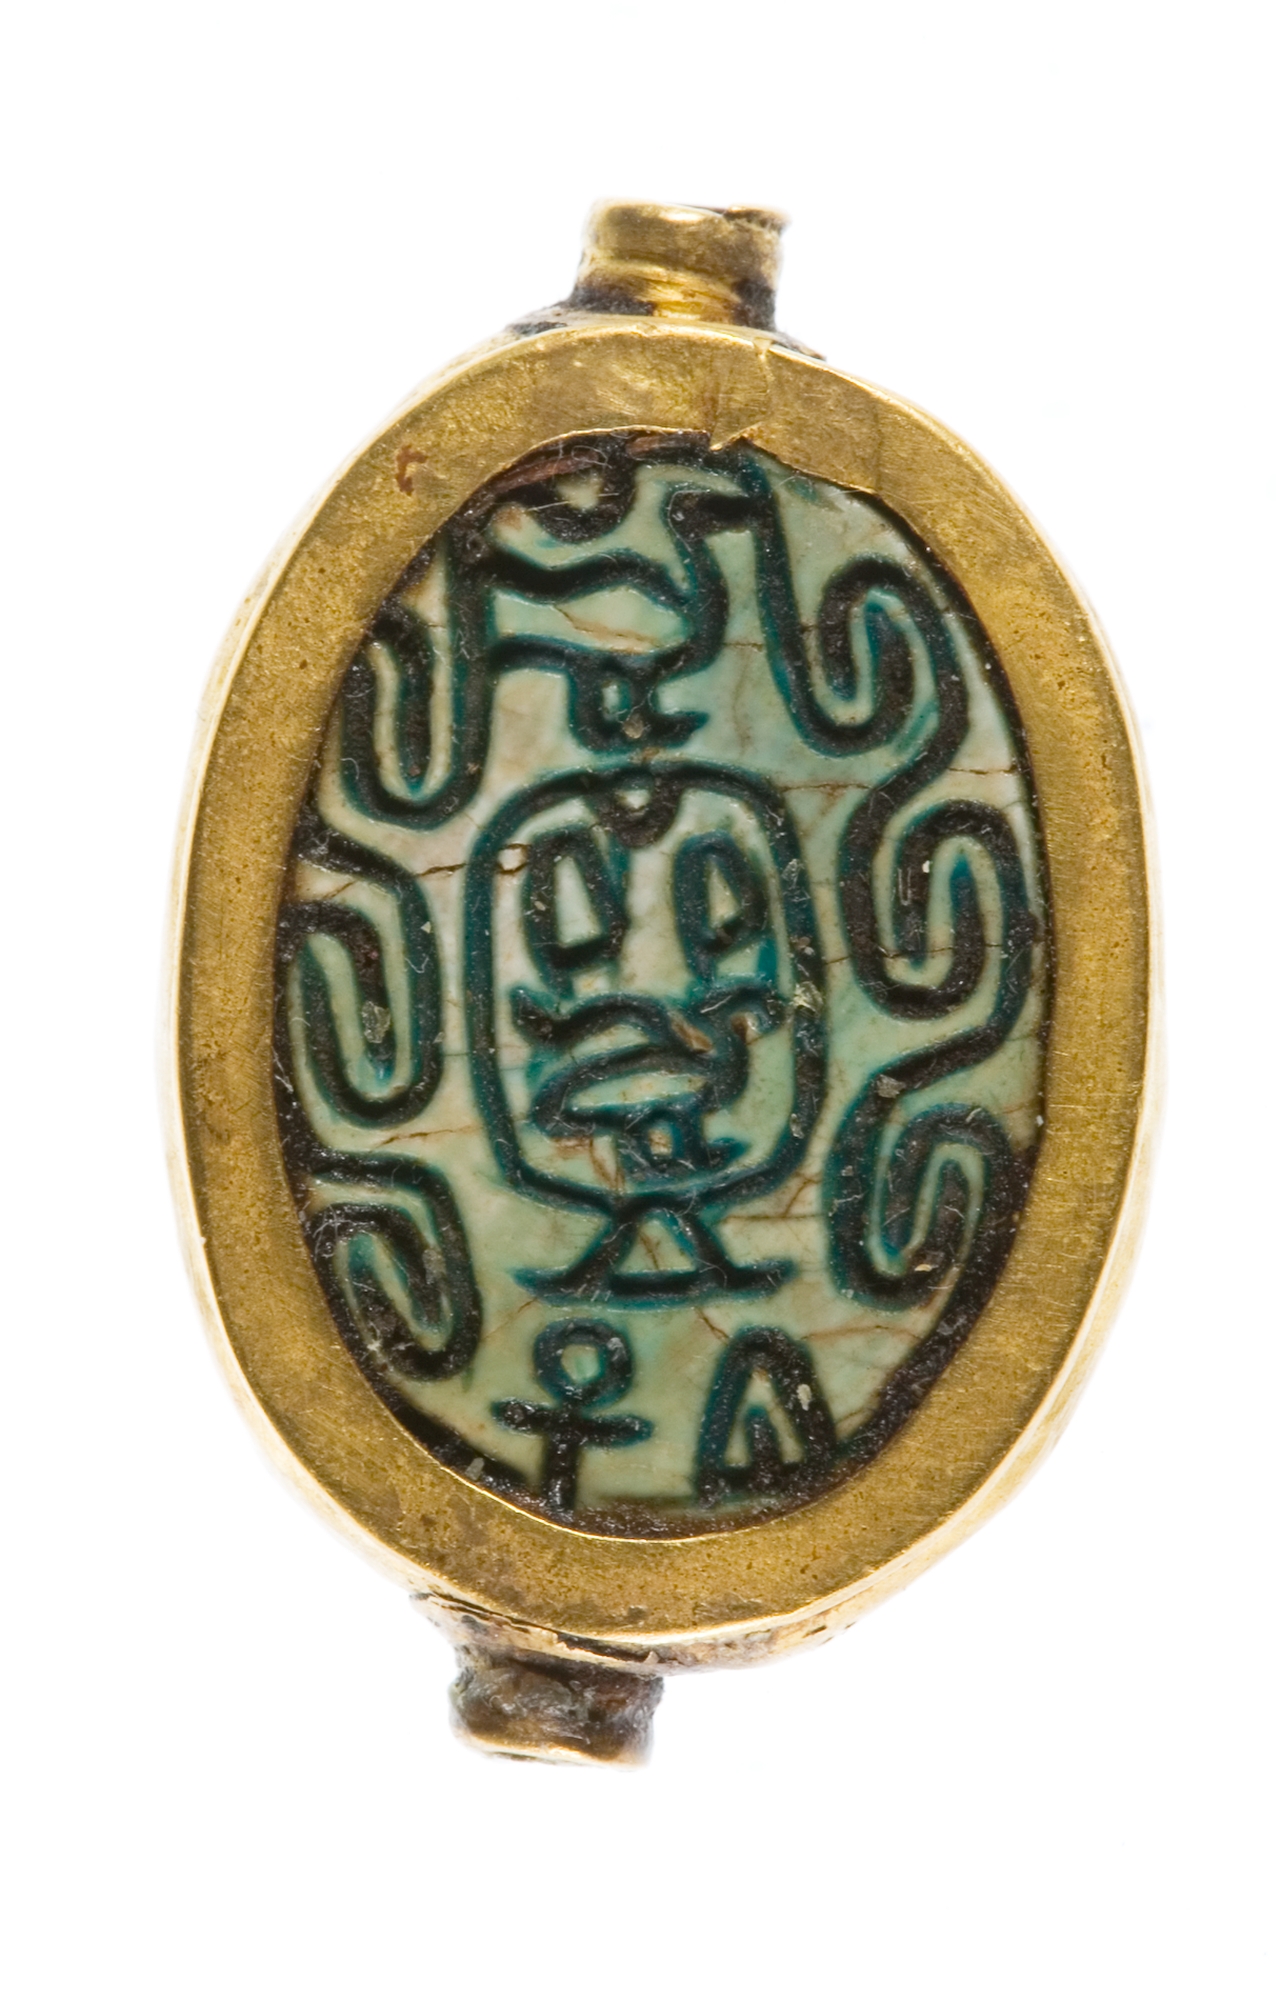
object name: scarab, khayan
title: Scarab with the Name of the Hyksos King Khayan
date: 1620-1581 BCE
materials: gold, stone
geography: egypt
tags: scarabs